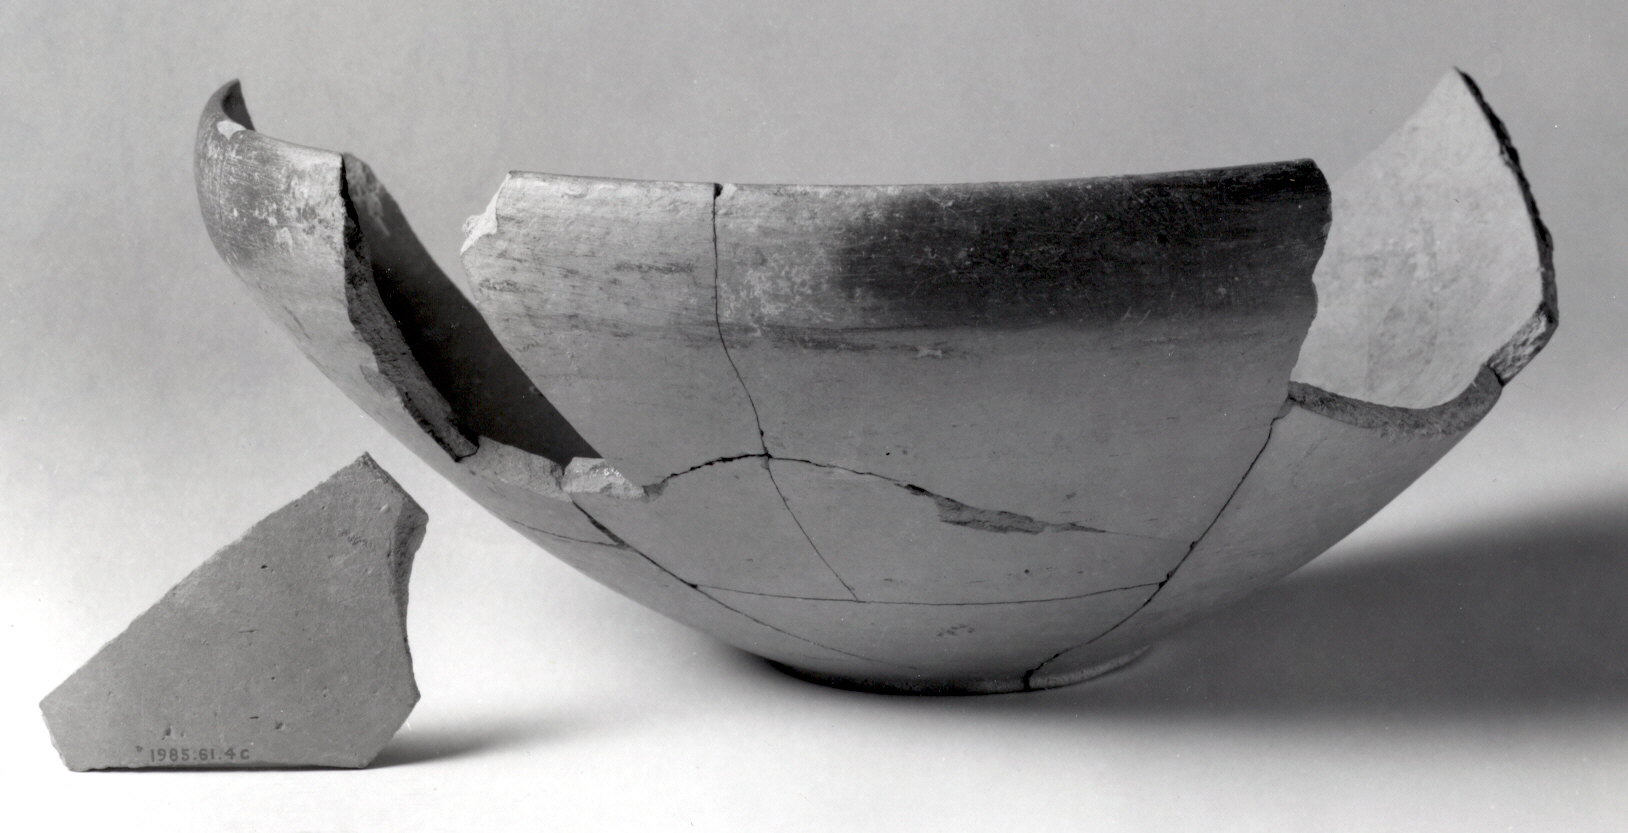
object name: bowl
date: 2350-2150 BCE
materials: ceramic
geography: syria